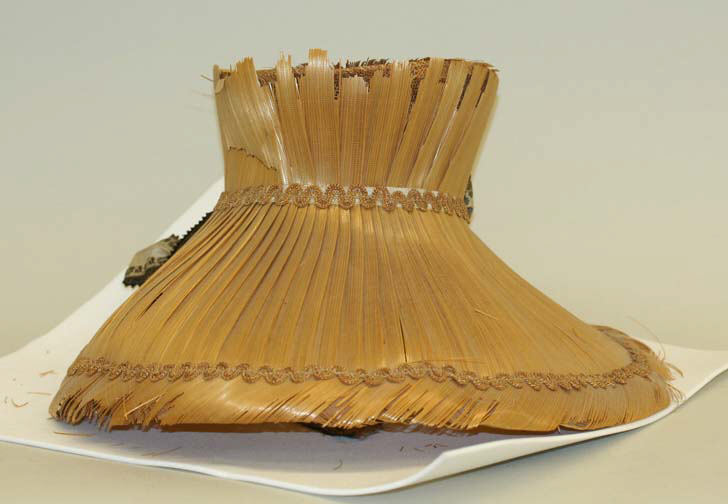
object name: poke bonnet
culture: american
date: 1831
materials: fiber